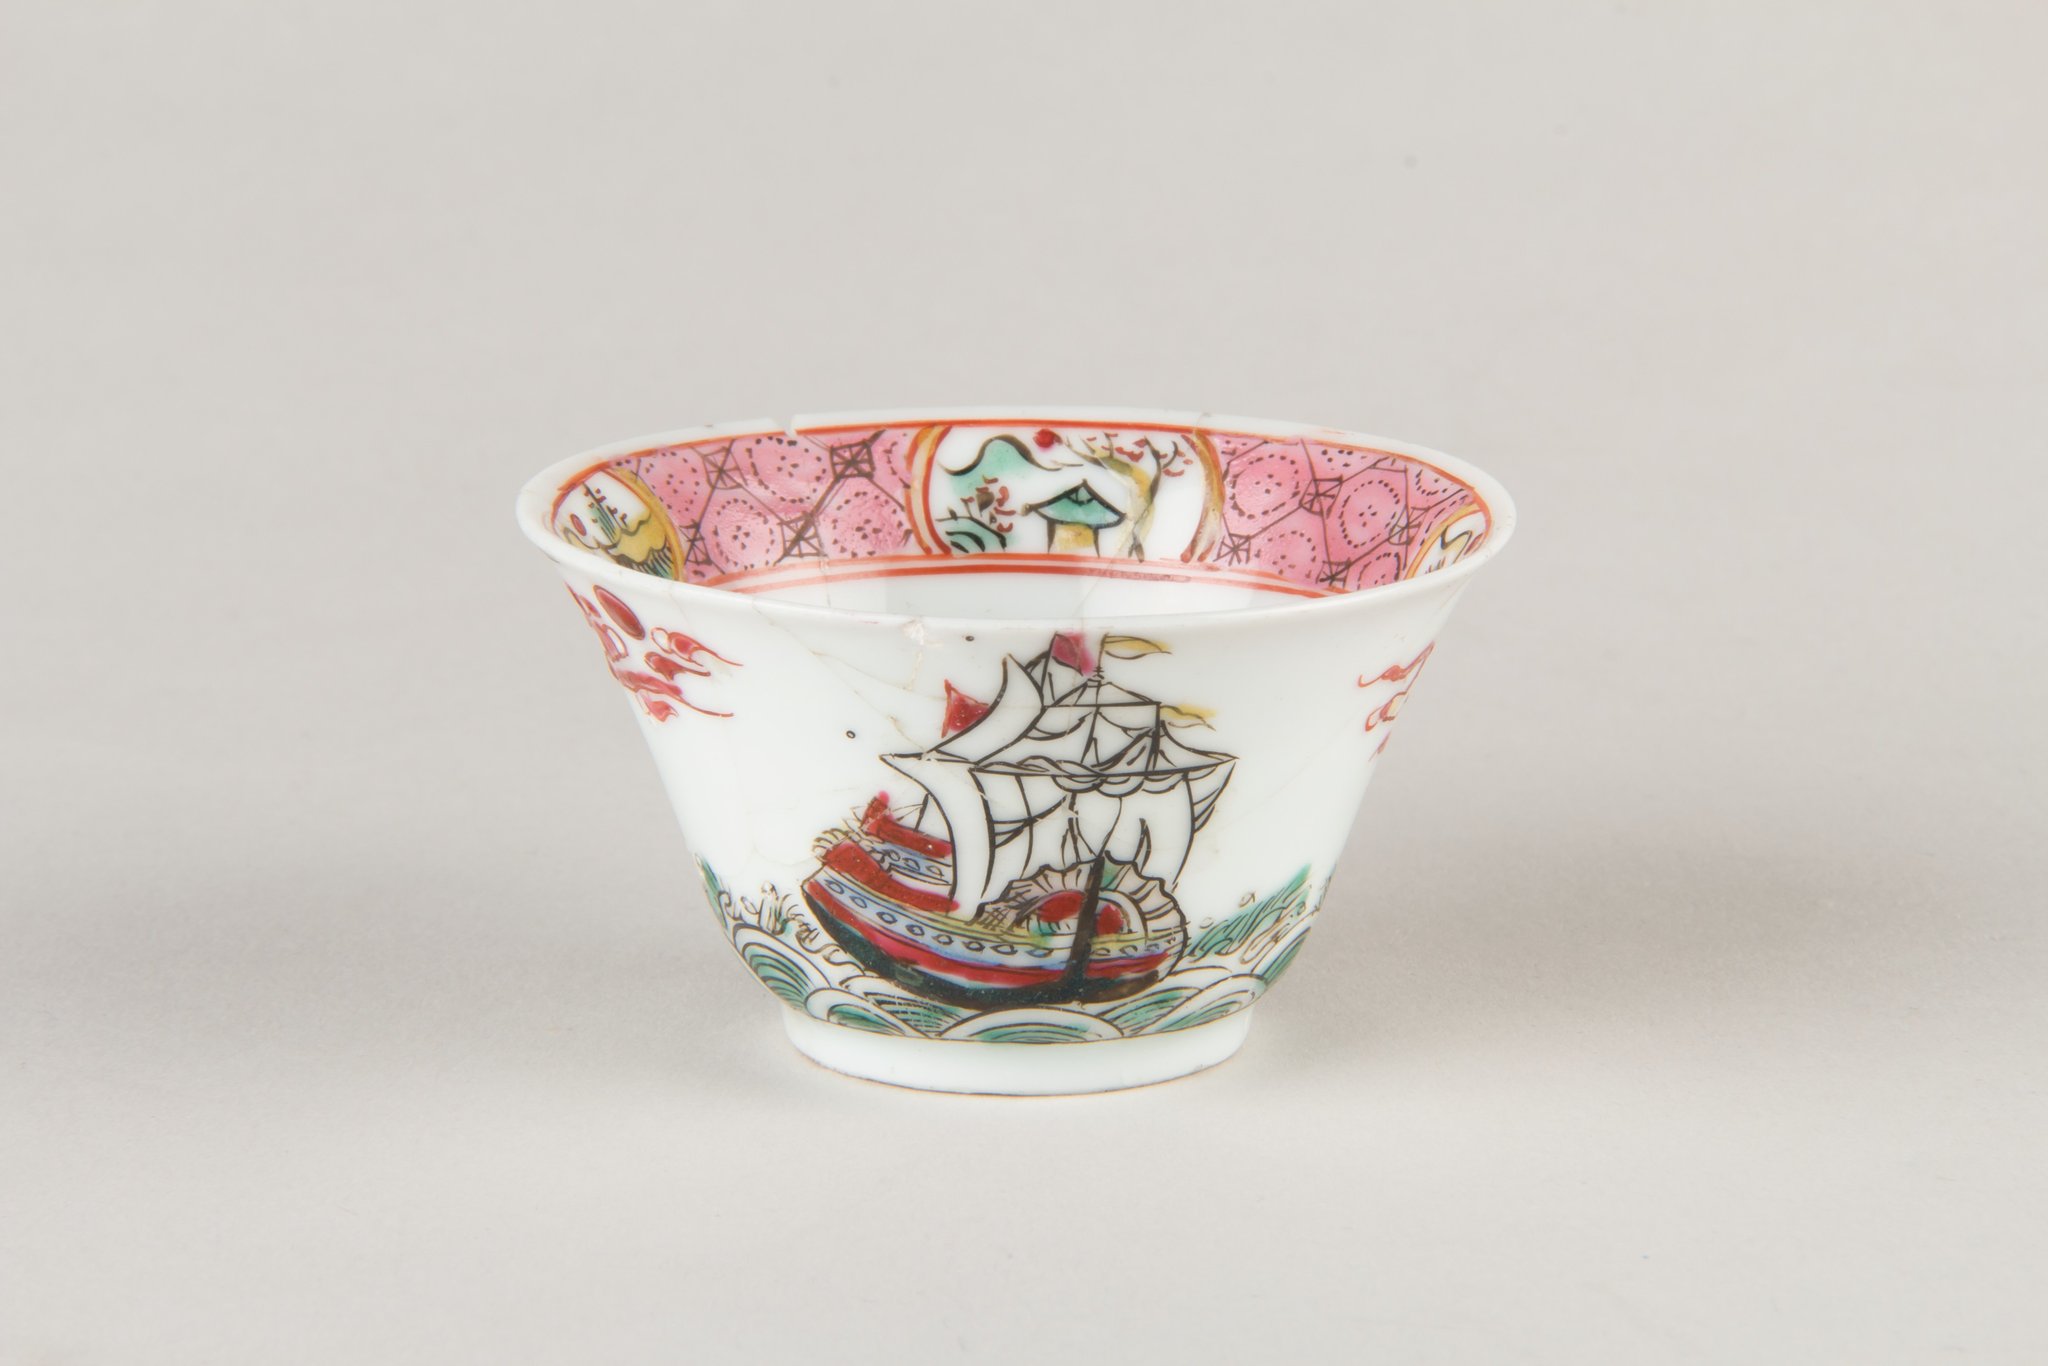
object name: cup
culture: chinese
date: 1736-1795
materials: porcelain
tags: flowers,boats,ships